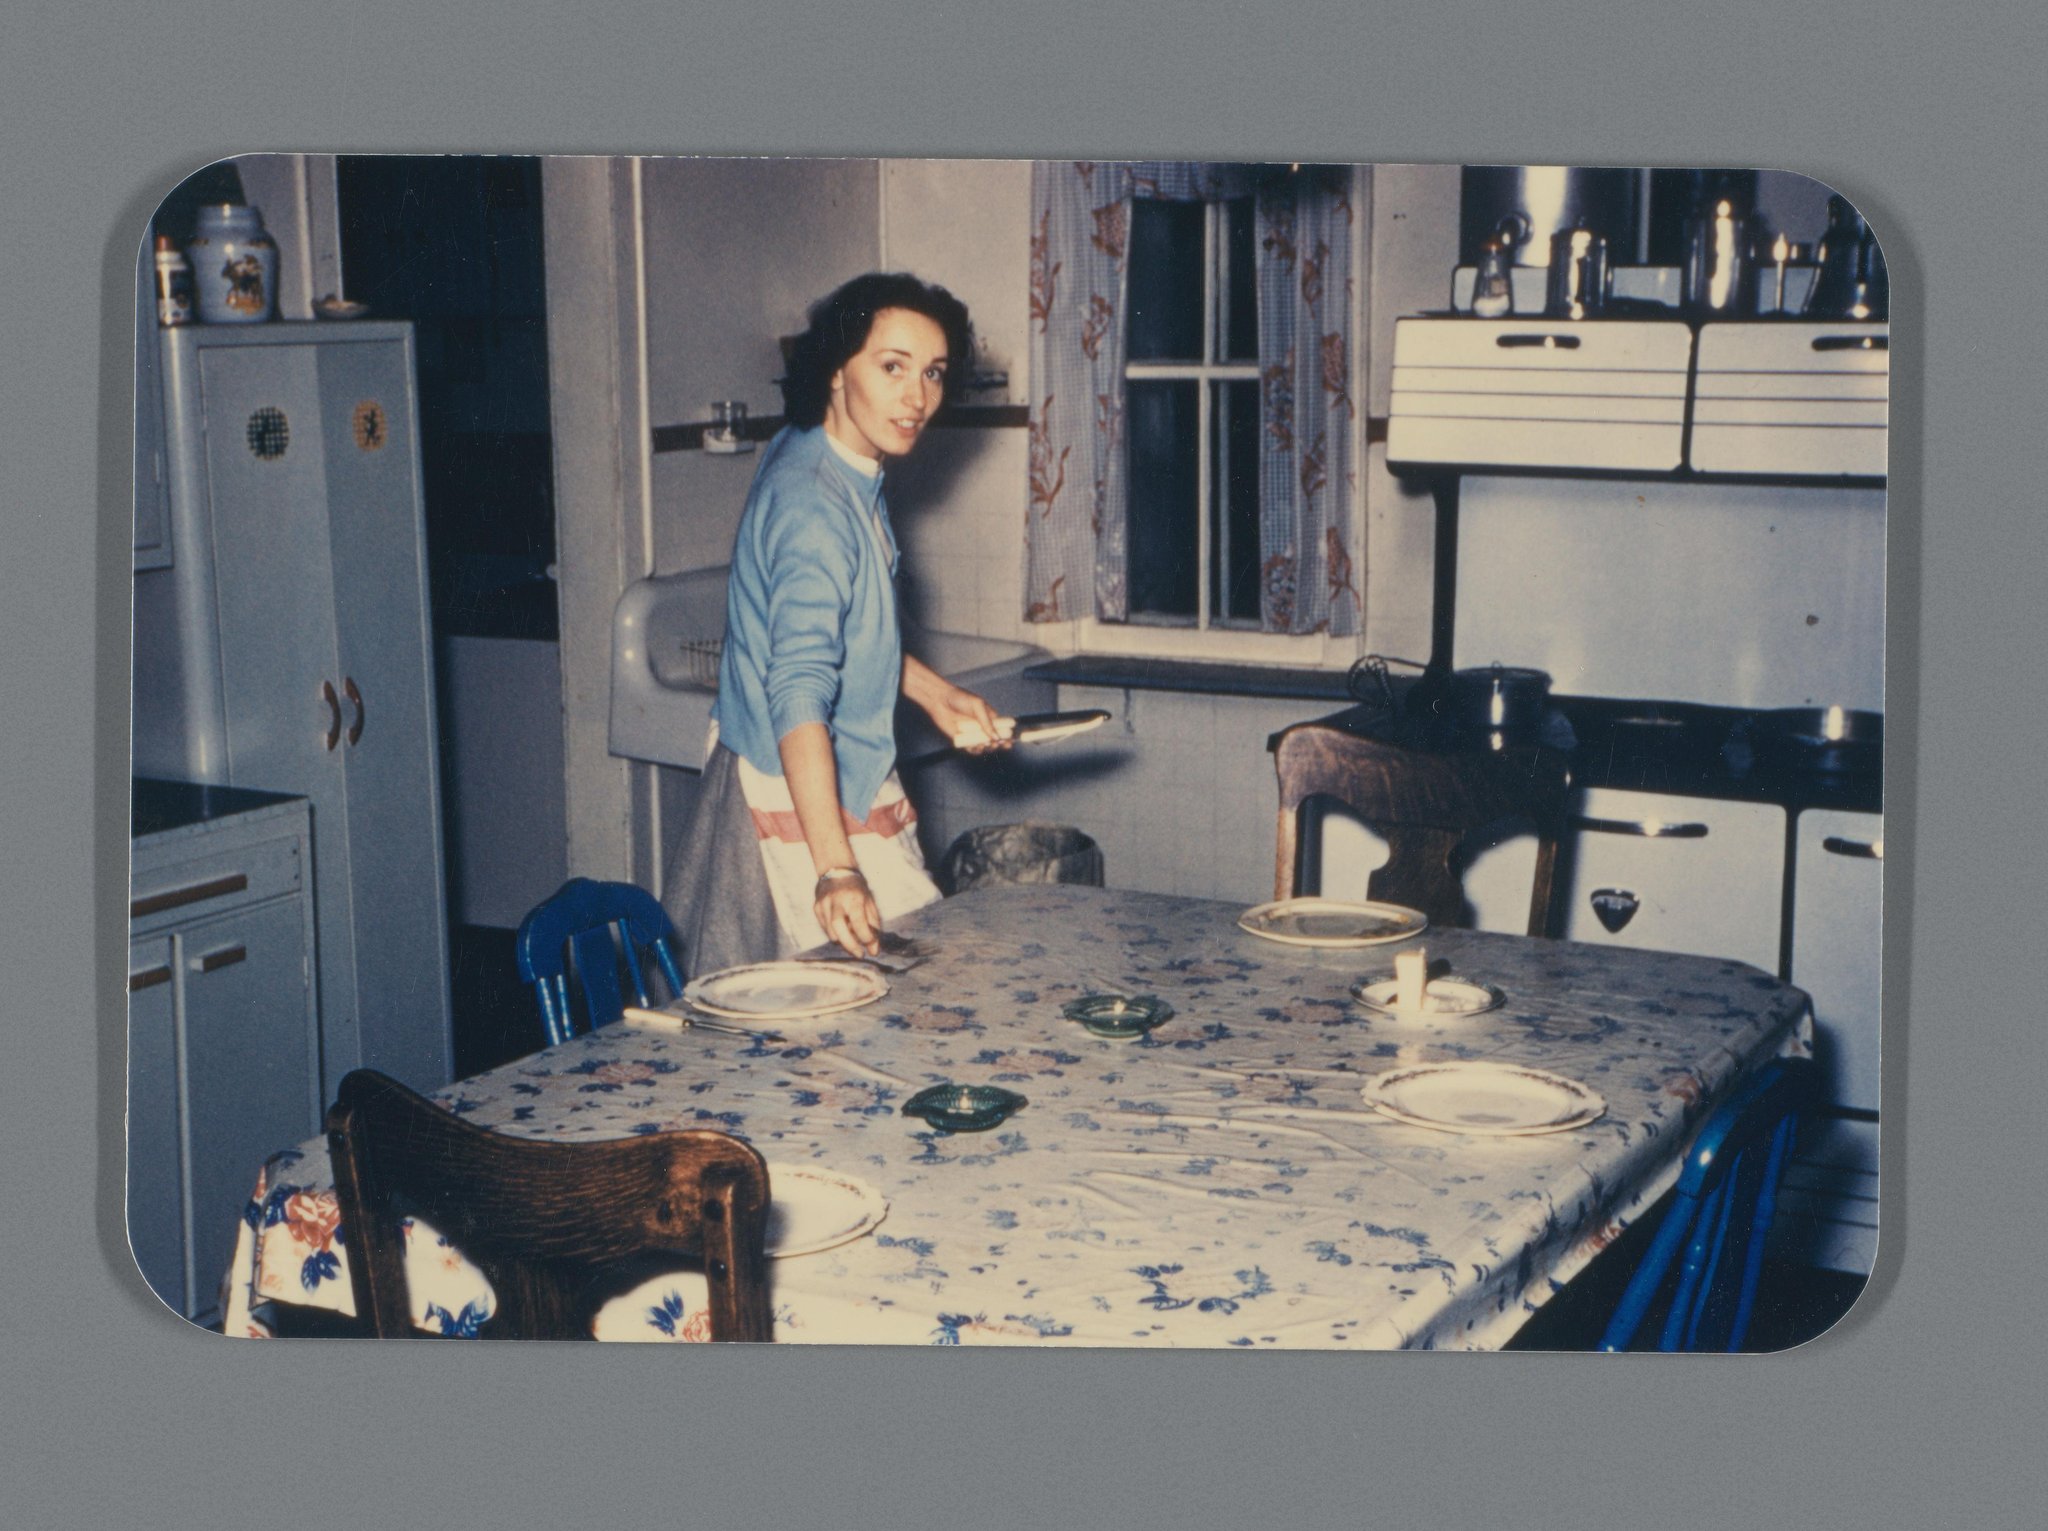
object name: photograph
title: Vrouw in blauw vest in de keuken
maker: Anonymous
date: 1948-1955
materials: photographic support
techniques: chromogenic print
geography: united states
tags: united states of america